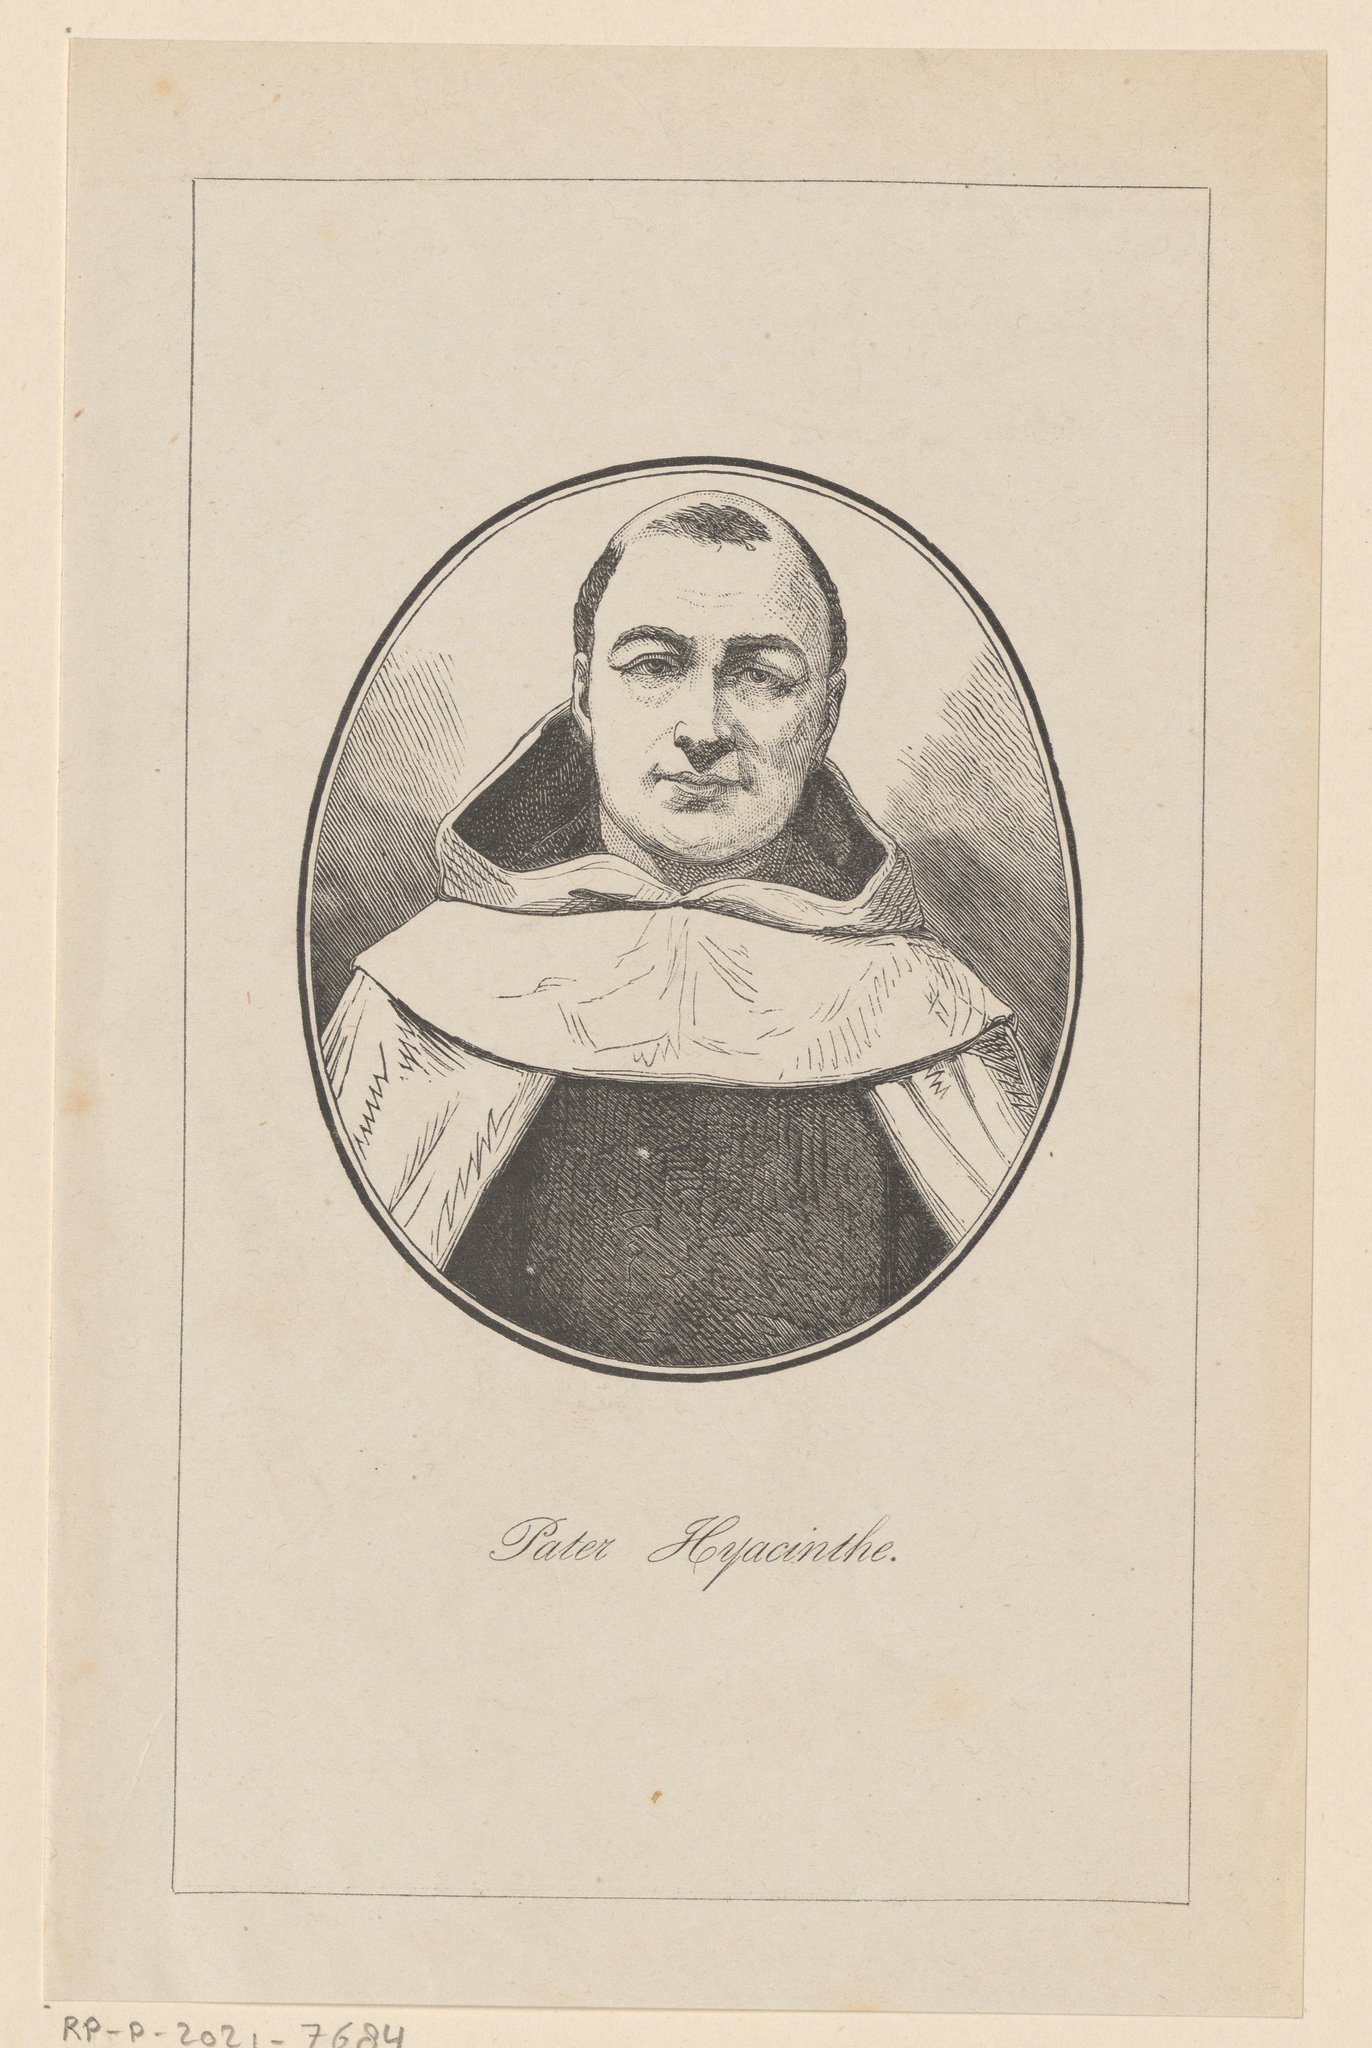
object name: print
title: Portret van Hyacinthe Loyson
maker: Anonymous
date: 1845-1899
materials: paper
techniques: letterpress printing, engraving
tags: theologian, historical persons, functionaries and dignitaries ~ episcopal protestant churches